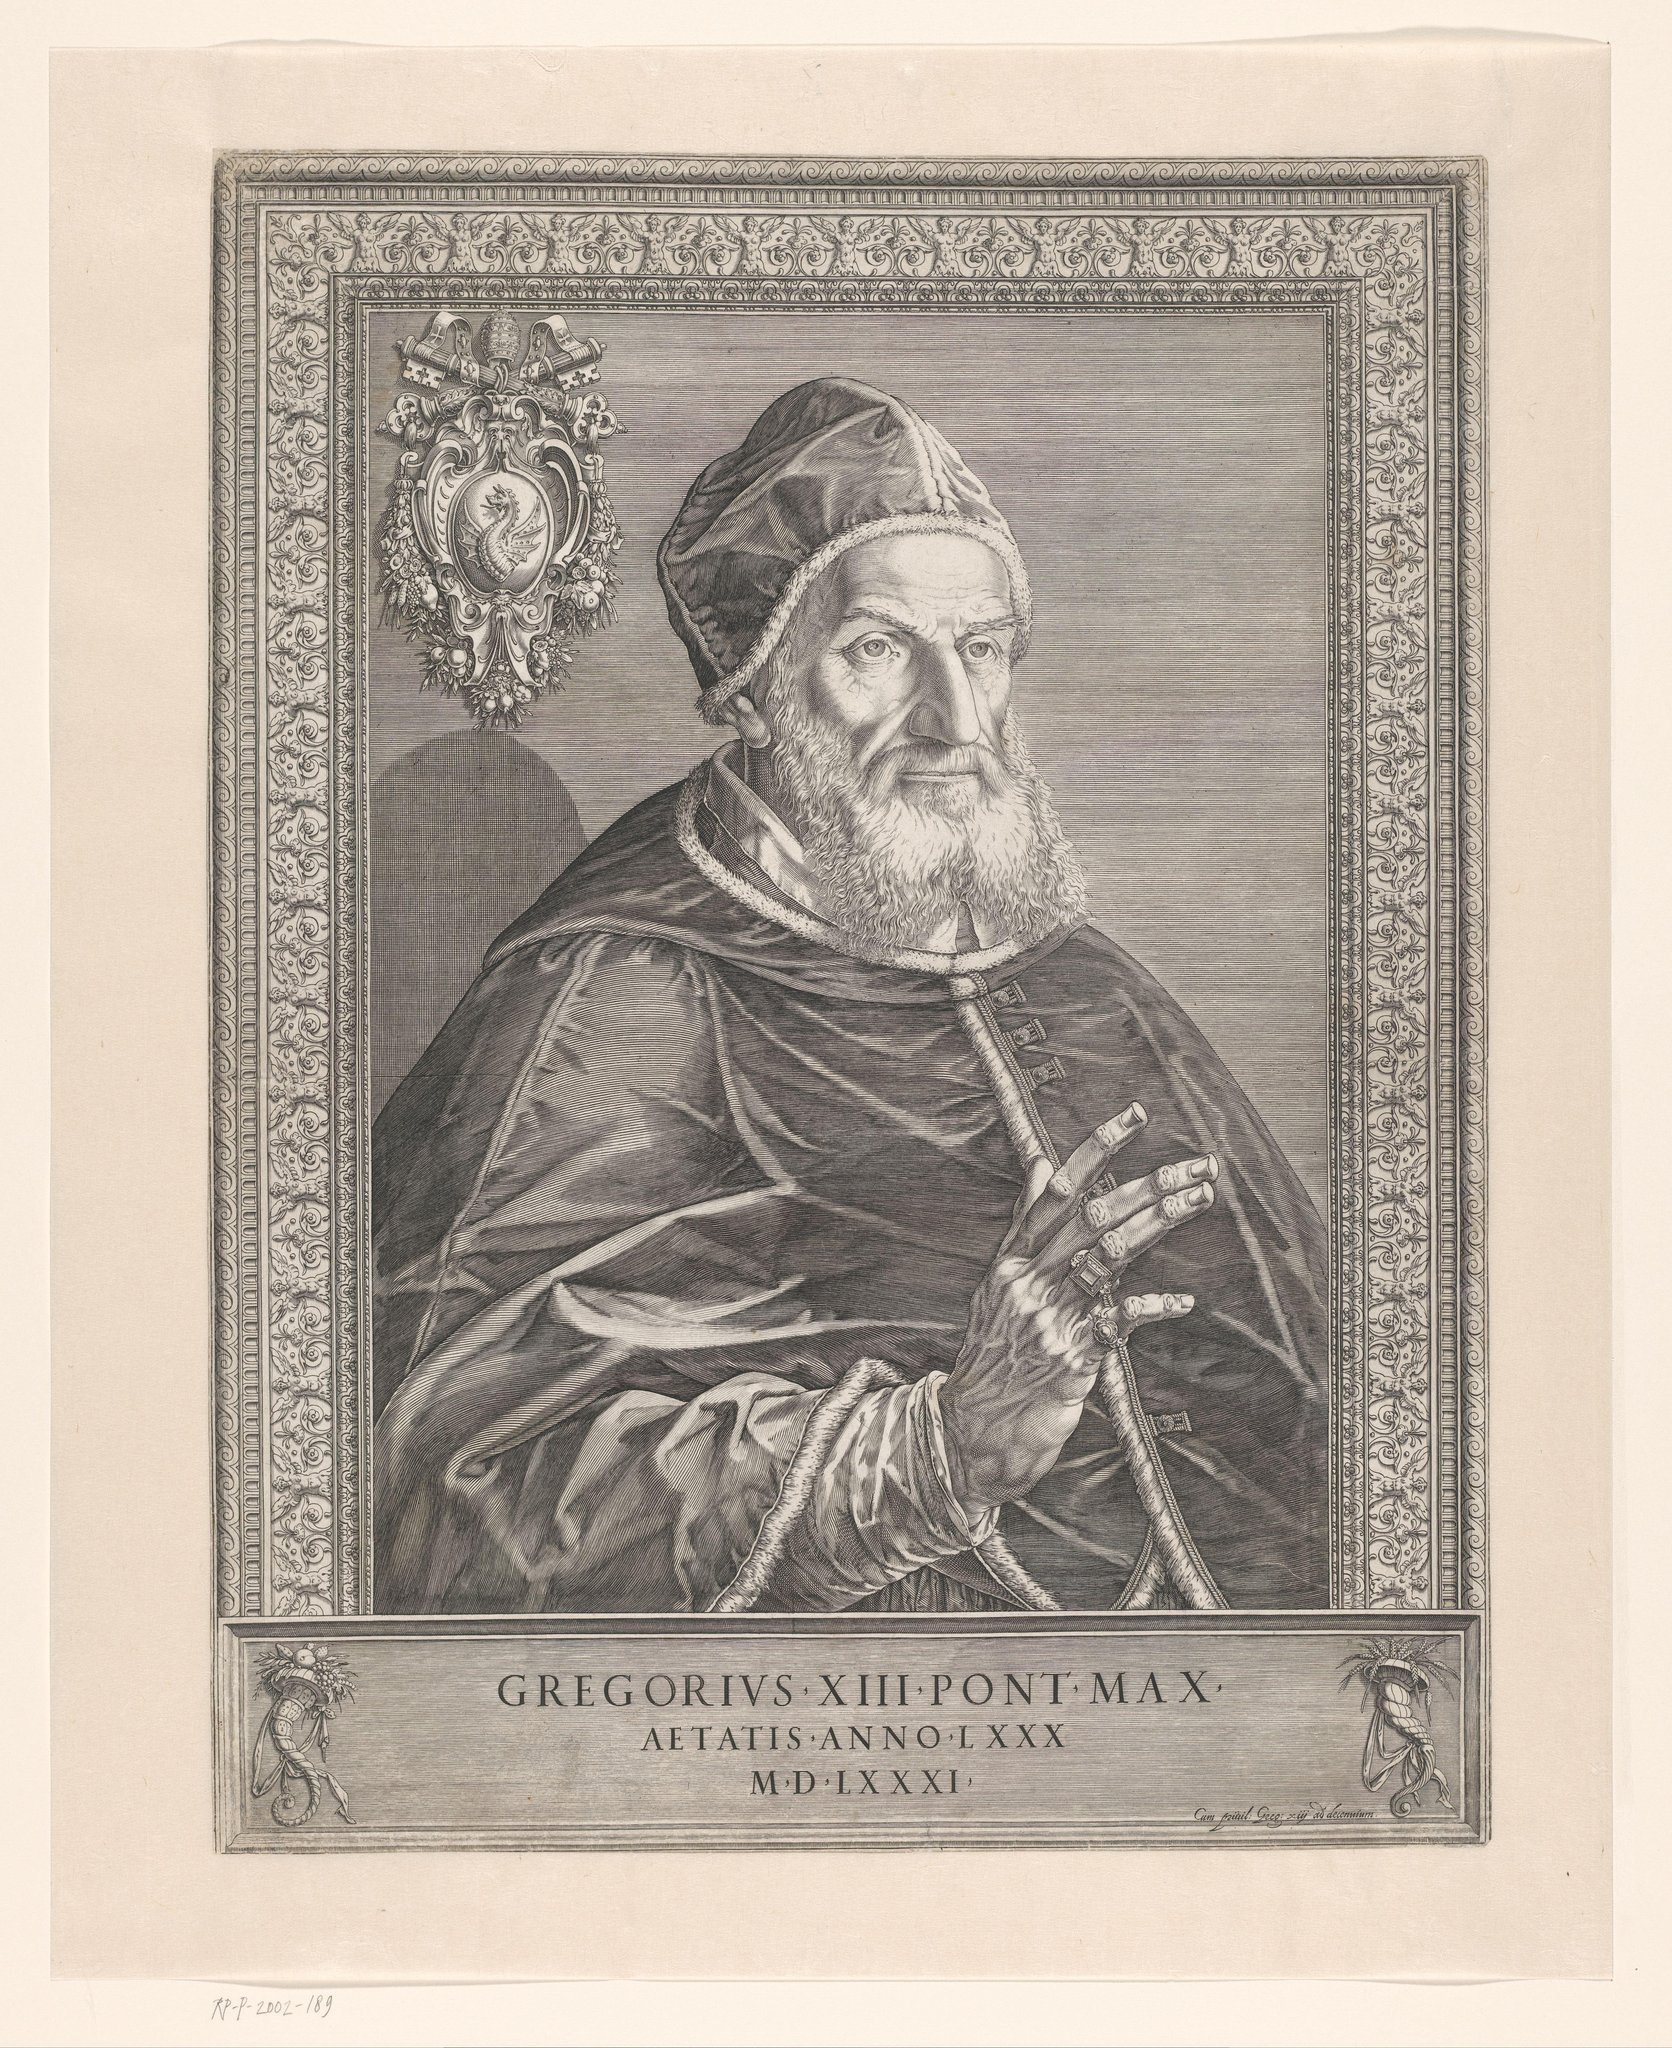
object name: print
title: Portret van paus Gregorius XIII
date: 1581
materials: paper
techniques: engraving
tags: rome, gregorius xiii, historical persons, pope, armorial bearing, heraldry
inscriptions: collector's mark: Lugt 2228, collector's mark: Lugt 2760